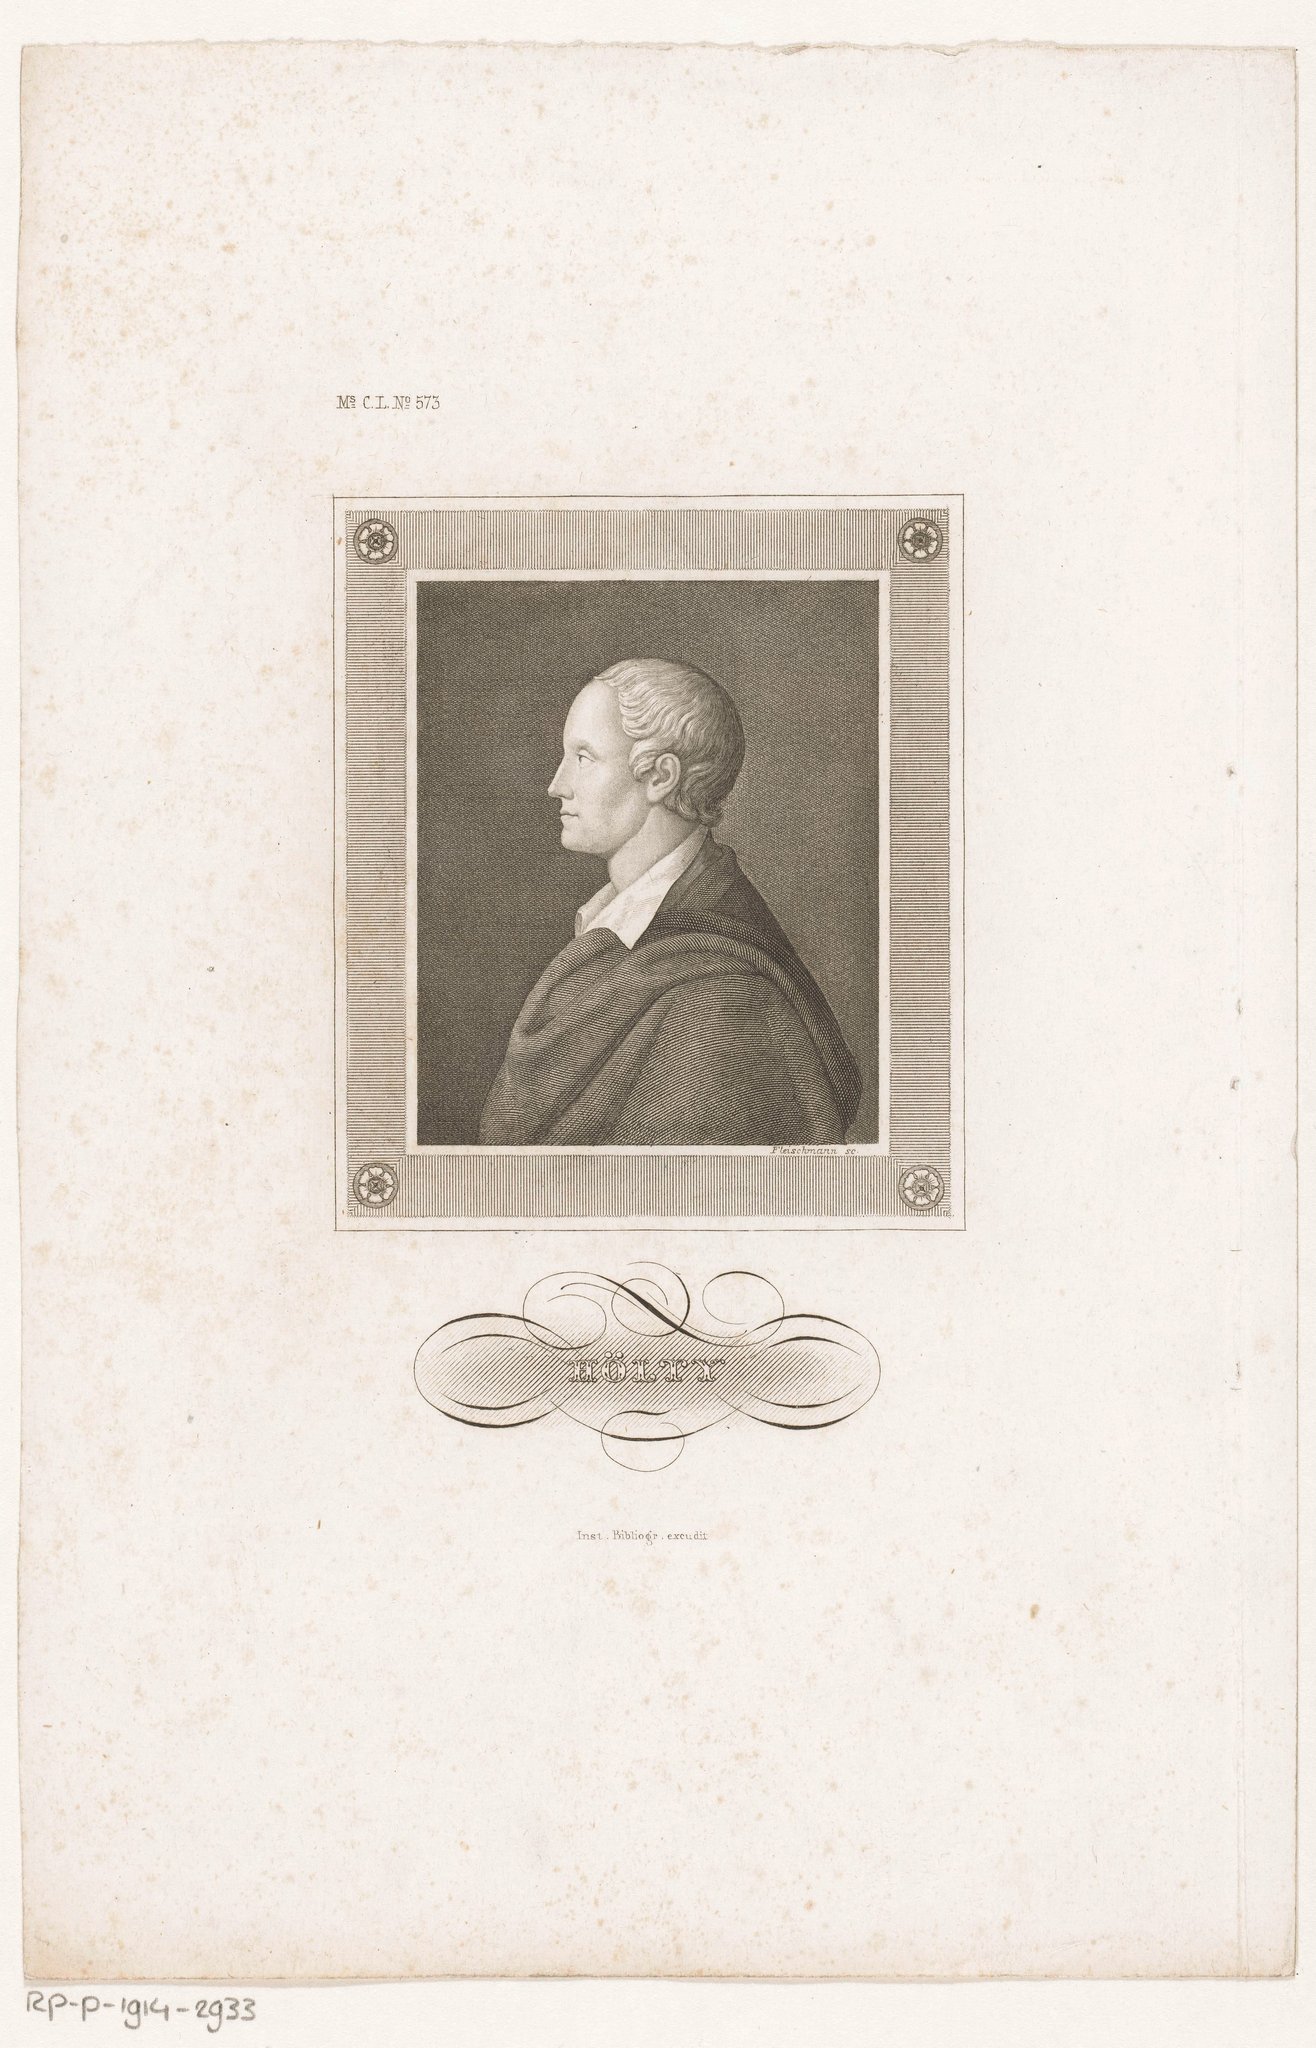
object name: print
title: Portret van Ludwig Hölty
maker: friedrich fleischmann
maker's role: print maker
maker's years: 1791-1834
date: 1840-1855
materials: paper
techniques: engraving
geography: gotha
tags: historical persons, writer, poet, author, calligraphy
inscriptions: collector's mark: Lugt 2228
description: Prent afkomstig uit: Conversations-Lexikon für die gebildeten Stände, voor het eerst uitgegeven tussen 1840-1855.